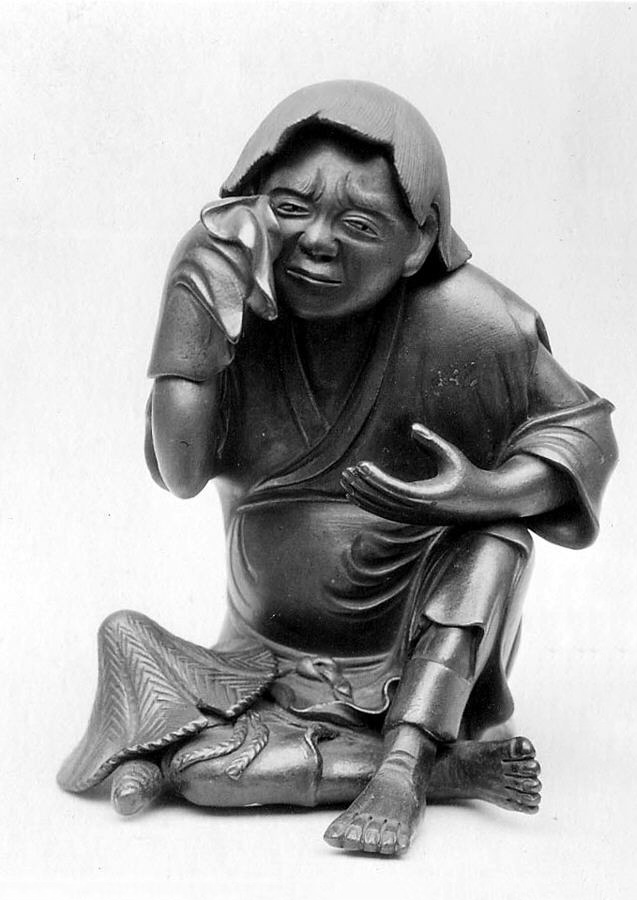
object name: figure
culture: japanese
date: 1760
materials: glaze, stoneware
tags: men